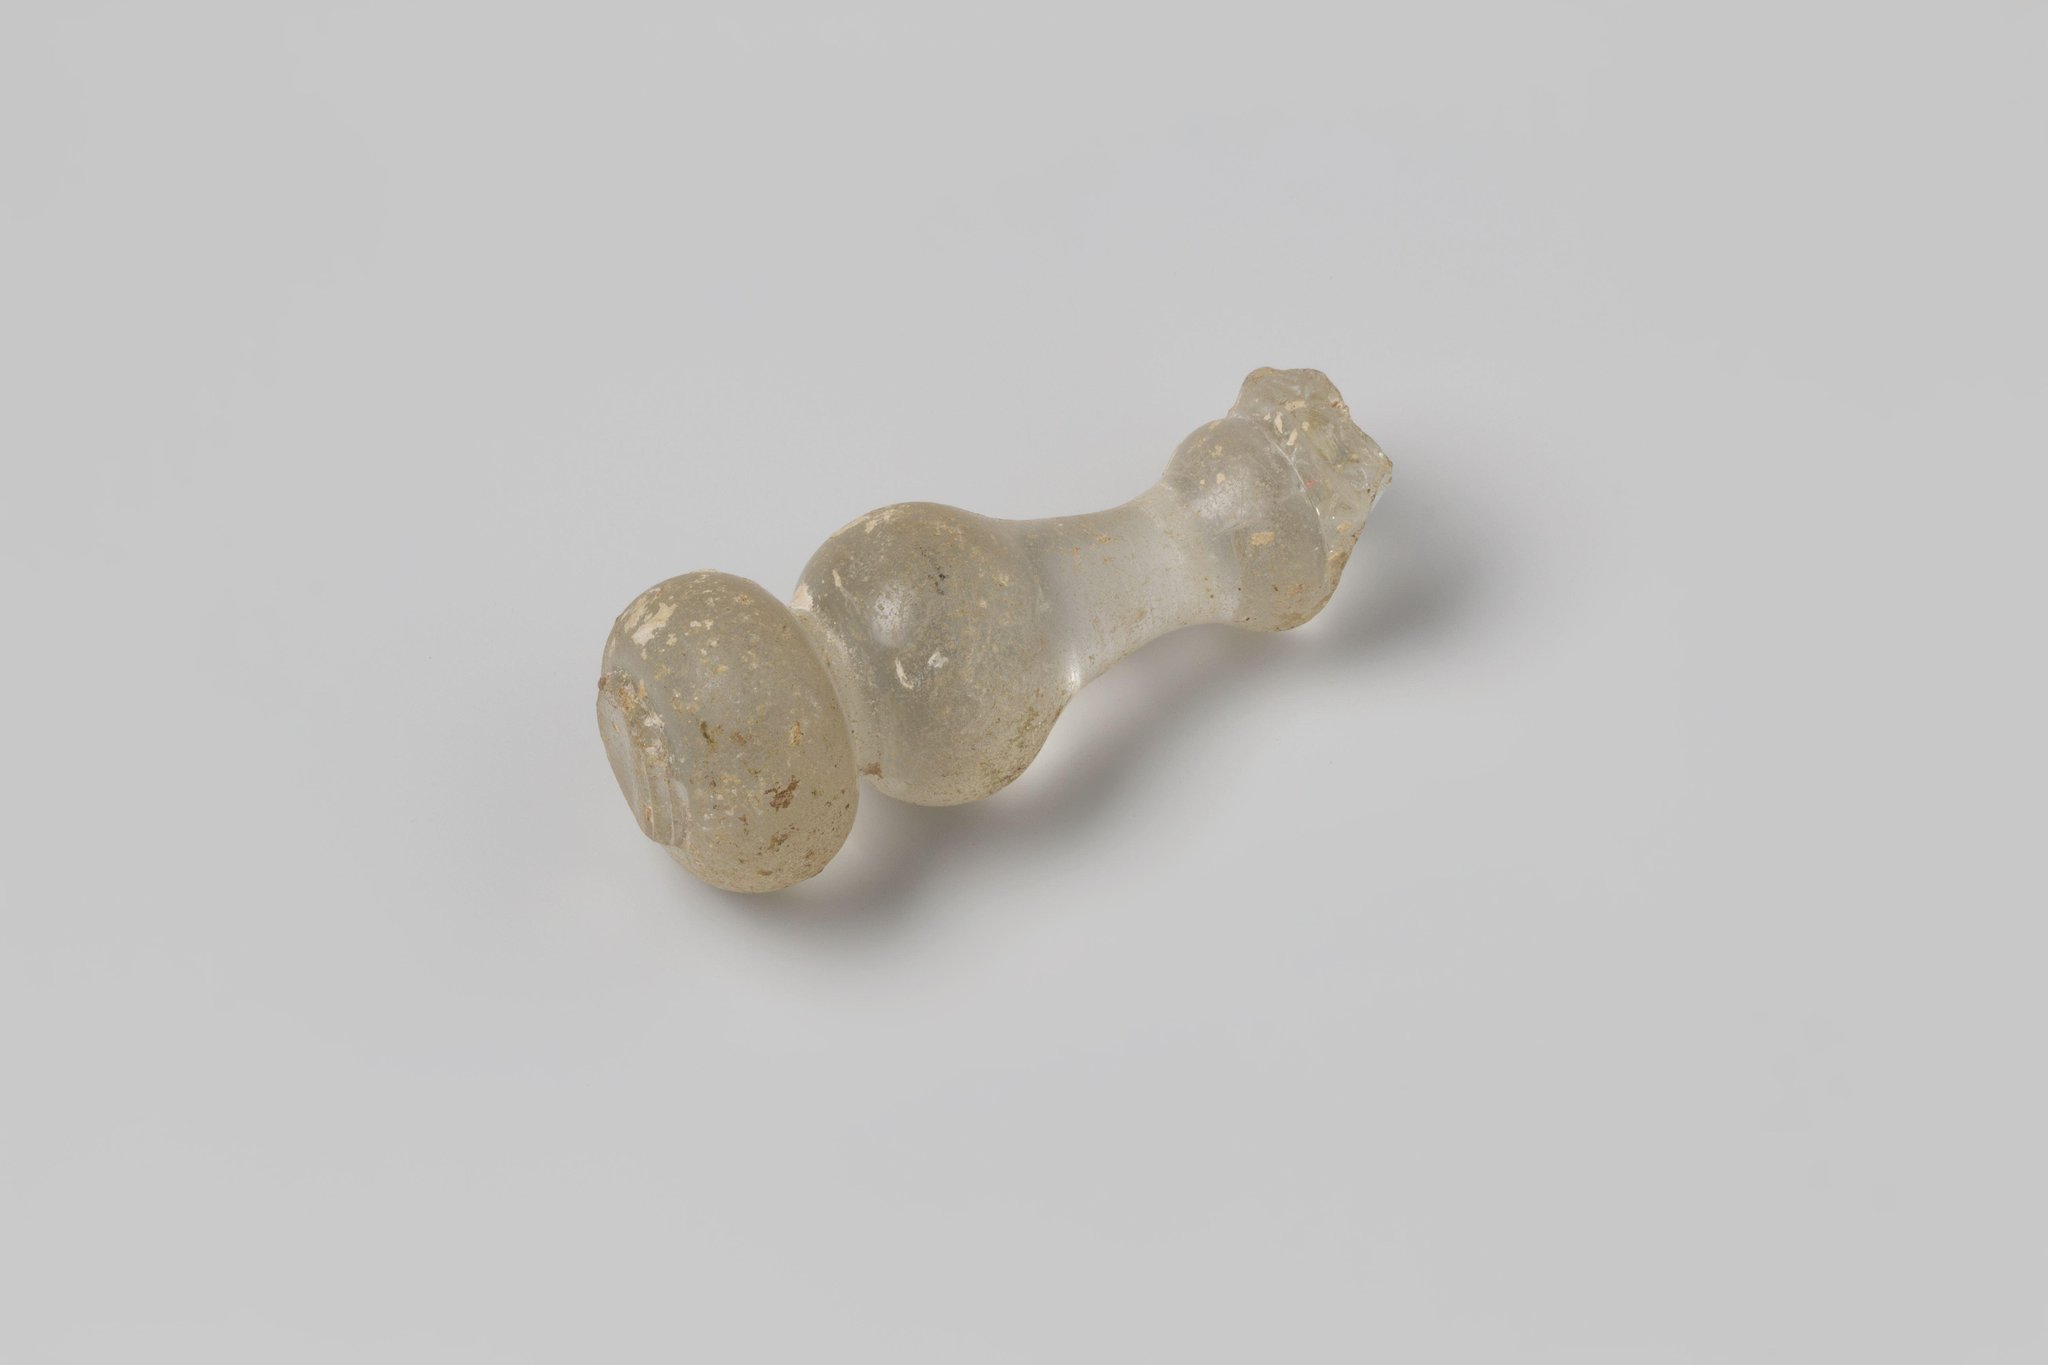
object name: helve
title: Balustervormige steel van een fluitglas uit het wrak van de Oost-Indiëvaarder Hollandia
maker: Anonymous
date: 1700-1743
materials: glass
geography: netherlands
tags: verenigde oostindische compagnie, hollandia (schip), annet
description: Glass, stem glass, steel, baluster-shaped; fragment, solid, constisting of an inverted baluster below a large flattened knop, broken, with a flattened knop at the junction of foot